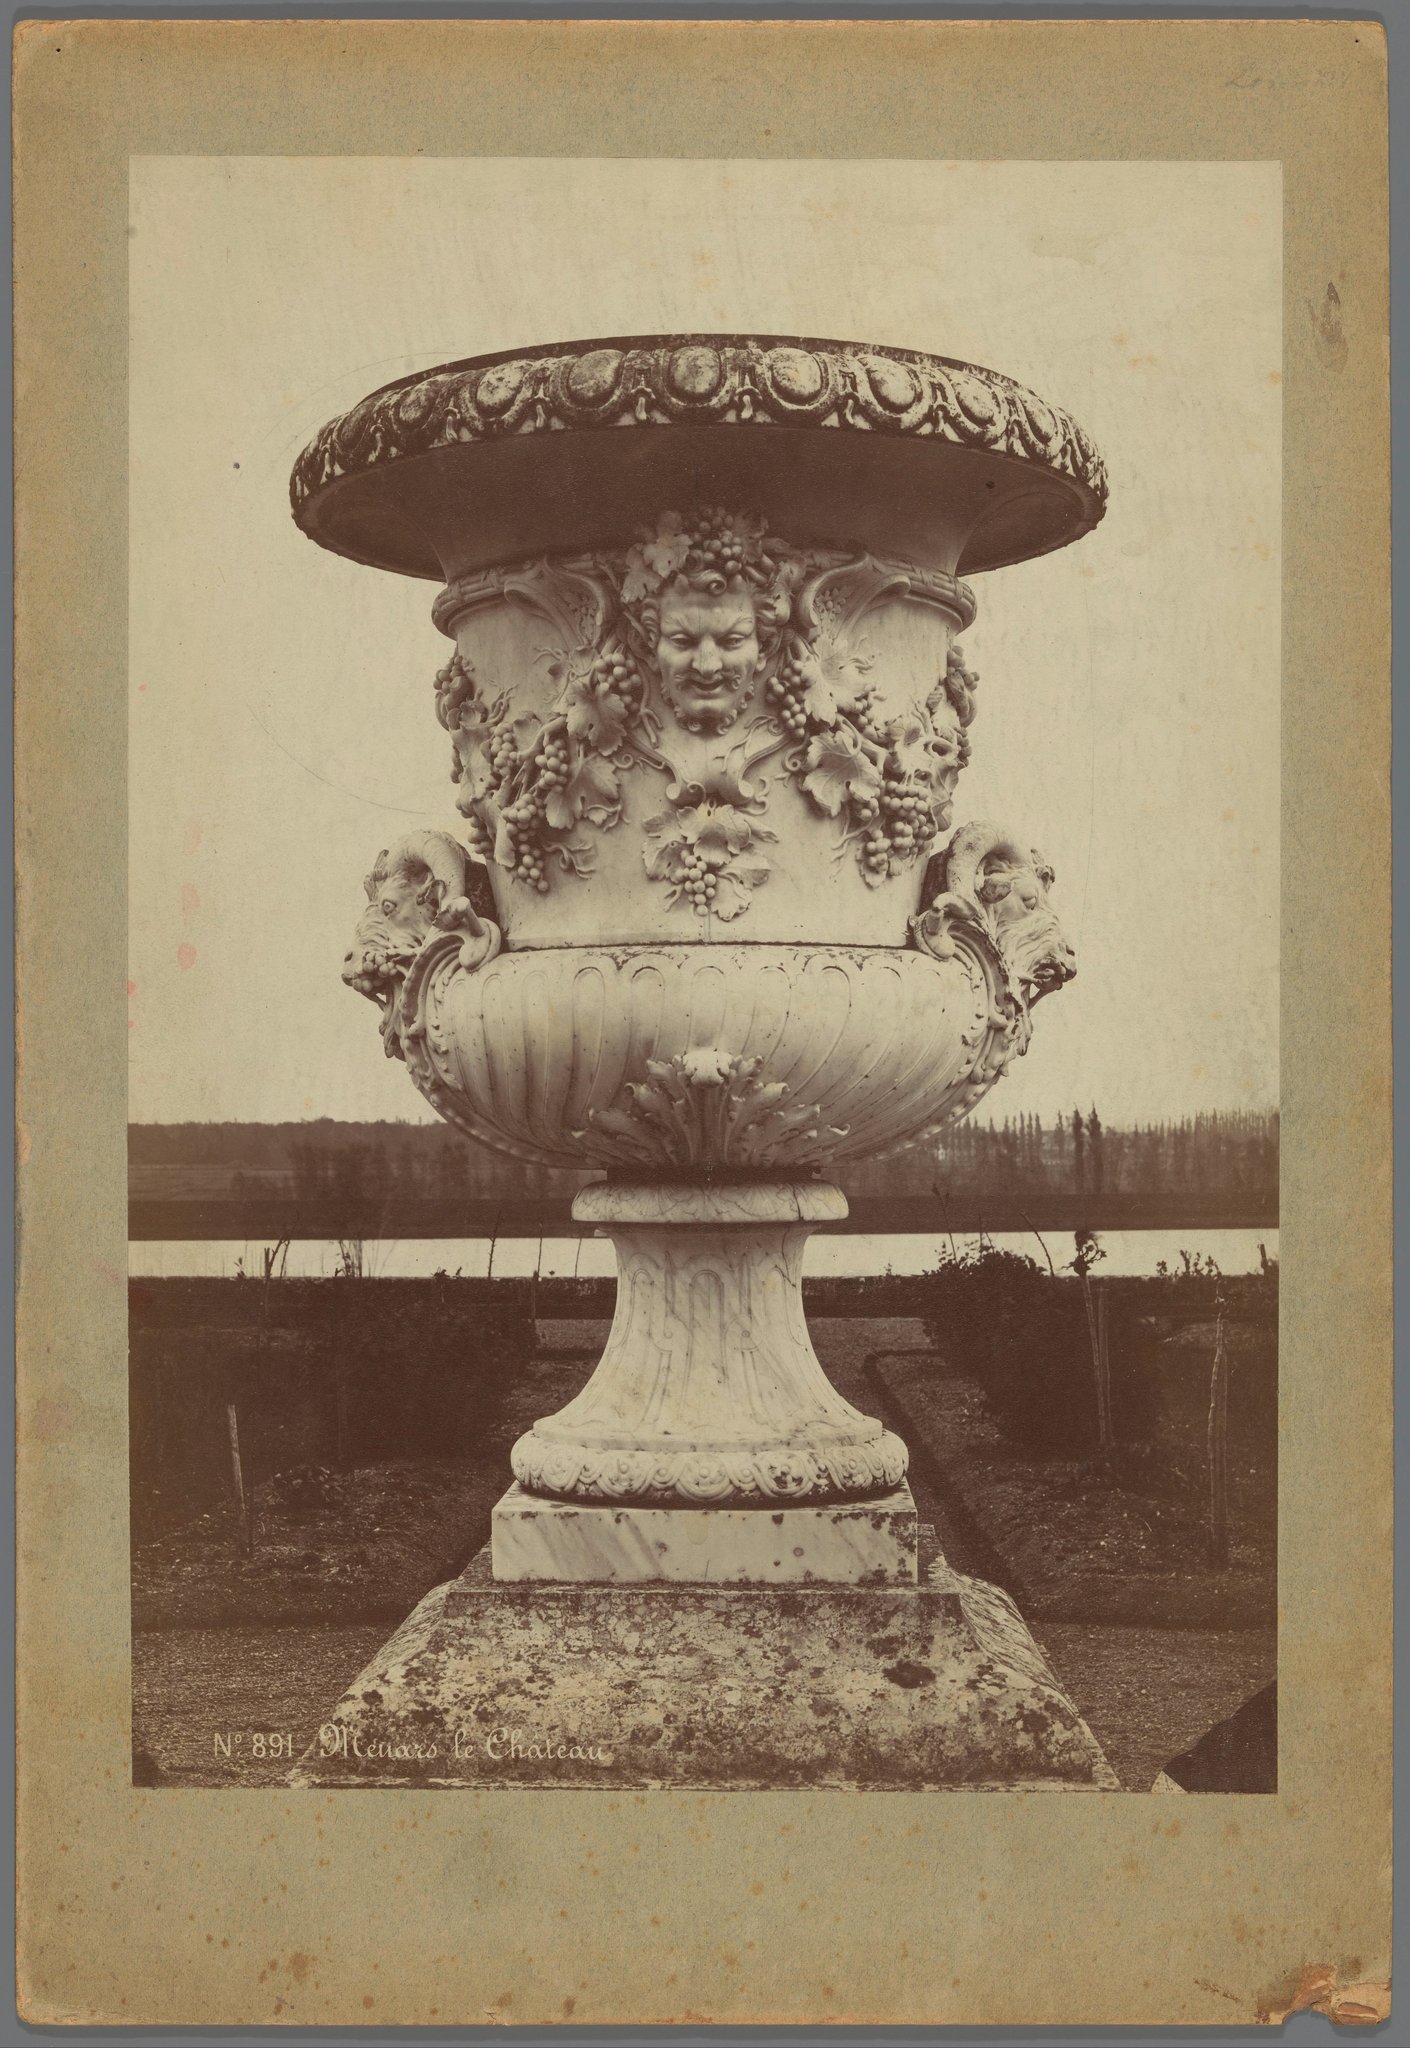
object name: photograph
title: Vaas met reliëf in de tuin van het Château van Menars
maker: séraphin-médéric mieusement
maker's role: fotograaf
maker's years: 1840-1905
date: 1875-1900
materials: cardboard, photographic support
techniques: albumen print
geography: menars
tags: mask, mascaron ~ ornament, garden vase, grape, sculpture (+ relief ~ sculpture)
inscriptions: number: ‘No. 891.’, name: ‘MIEUSEMENT PHOTOGRAPHE’, inscription: ‘MONUMENTS HISTORIQUES’, collector's mark: Lugt 3937, inscription: ‘Louis XIV’, name: ‘KUNSTBOEKHANDEL J. A. G. DE LEUR PHOTOGRAAF - UITGEVER HUIGENSPARK, 40b. DEN HAAG.’